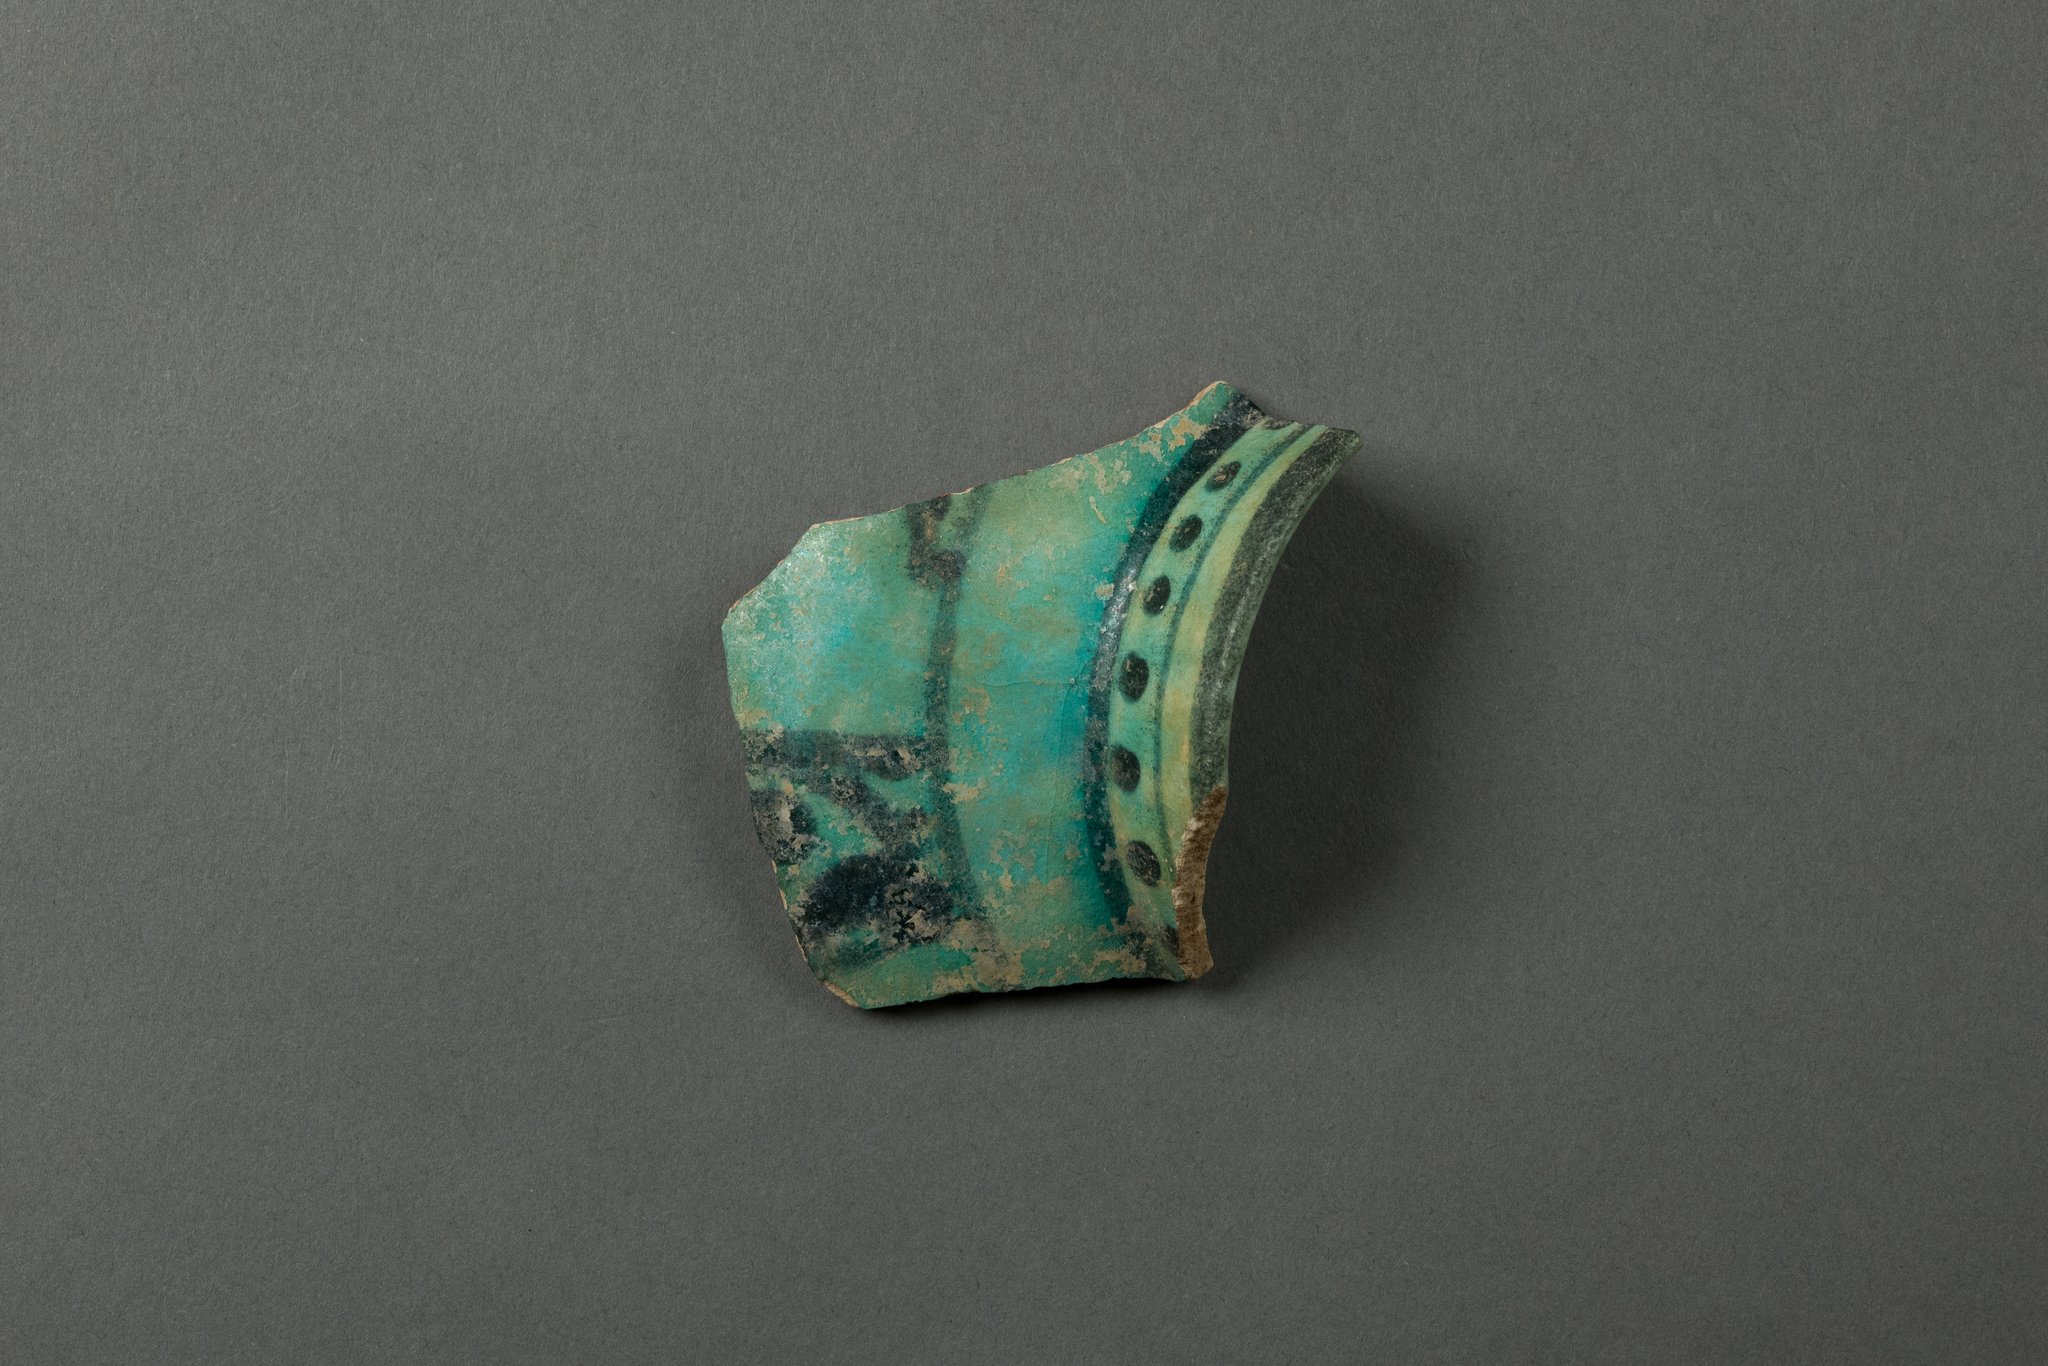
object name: fragment of a jar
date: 1001-1200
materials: earthenware, glaze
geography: iran